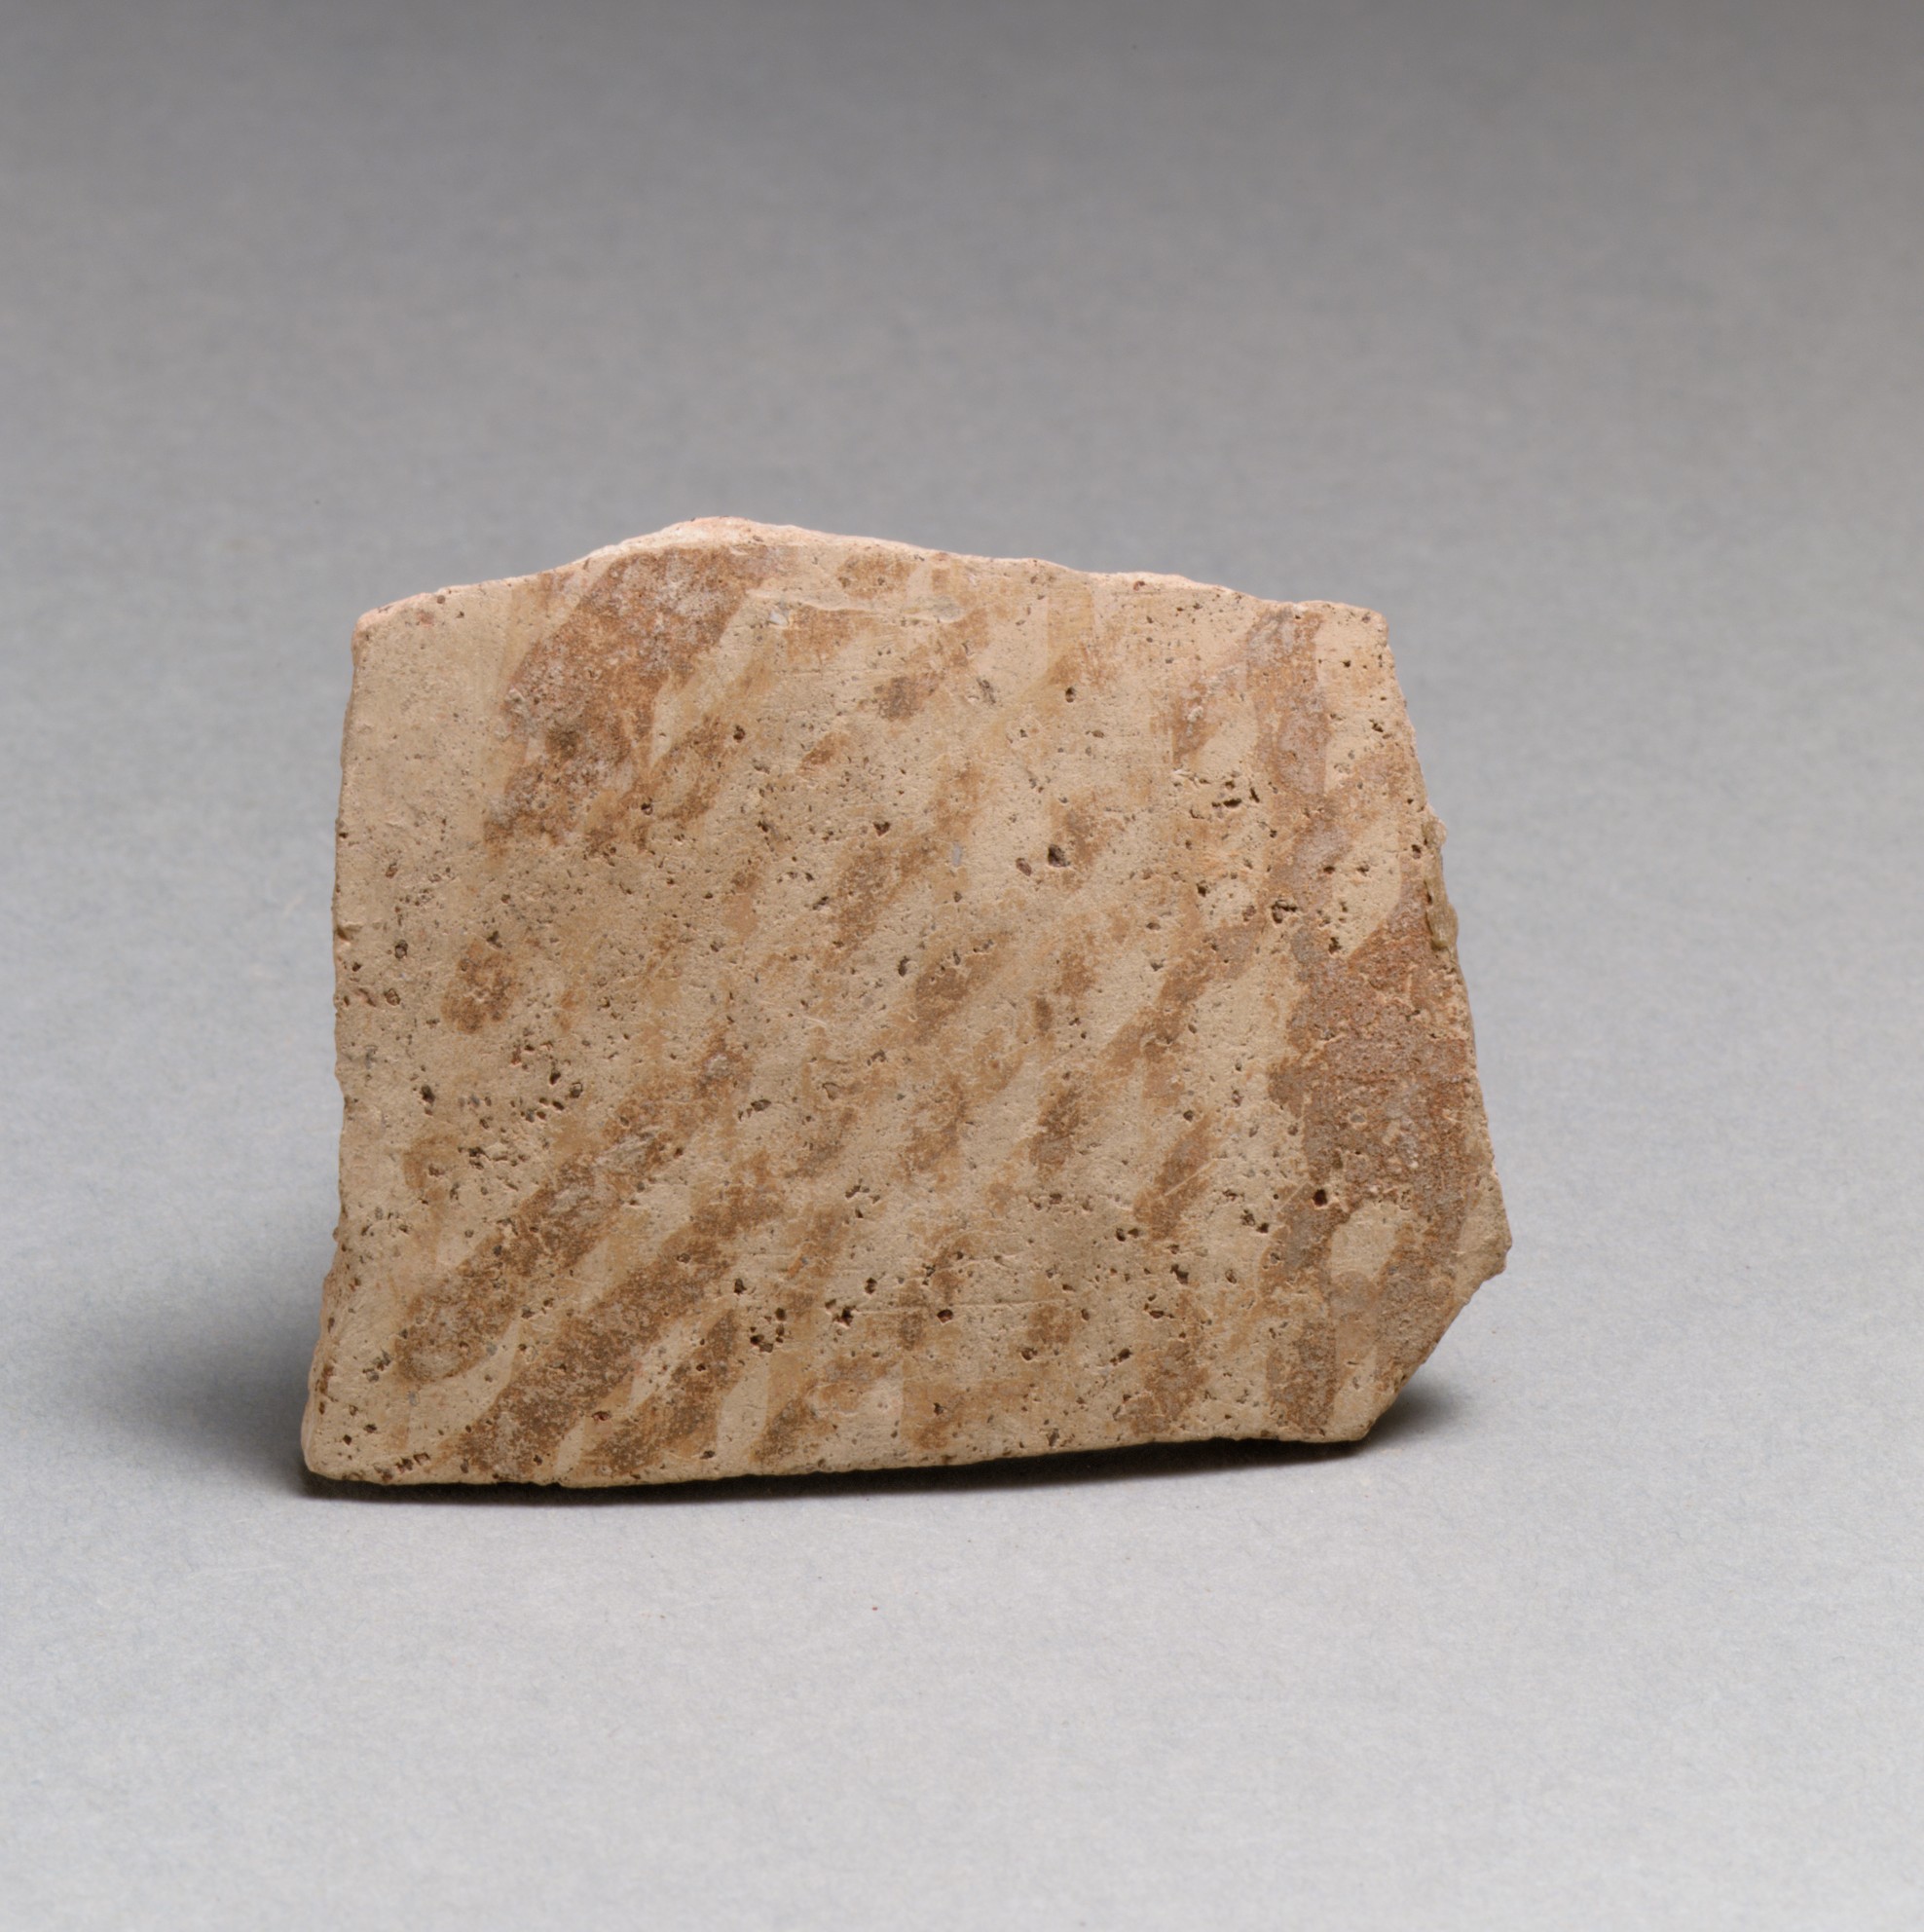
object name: vase fragment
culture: minoan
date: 2600-2000 BCE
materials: terracotta